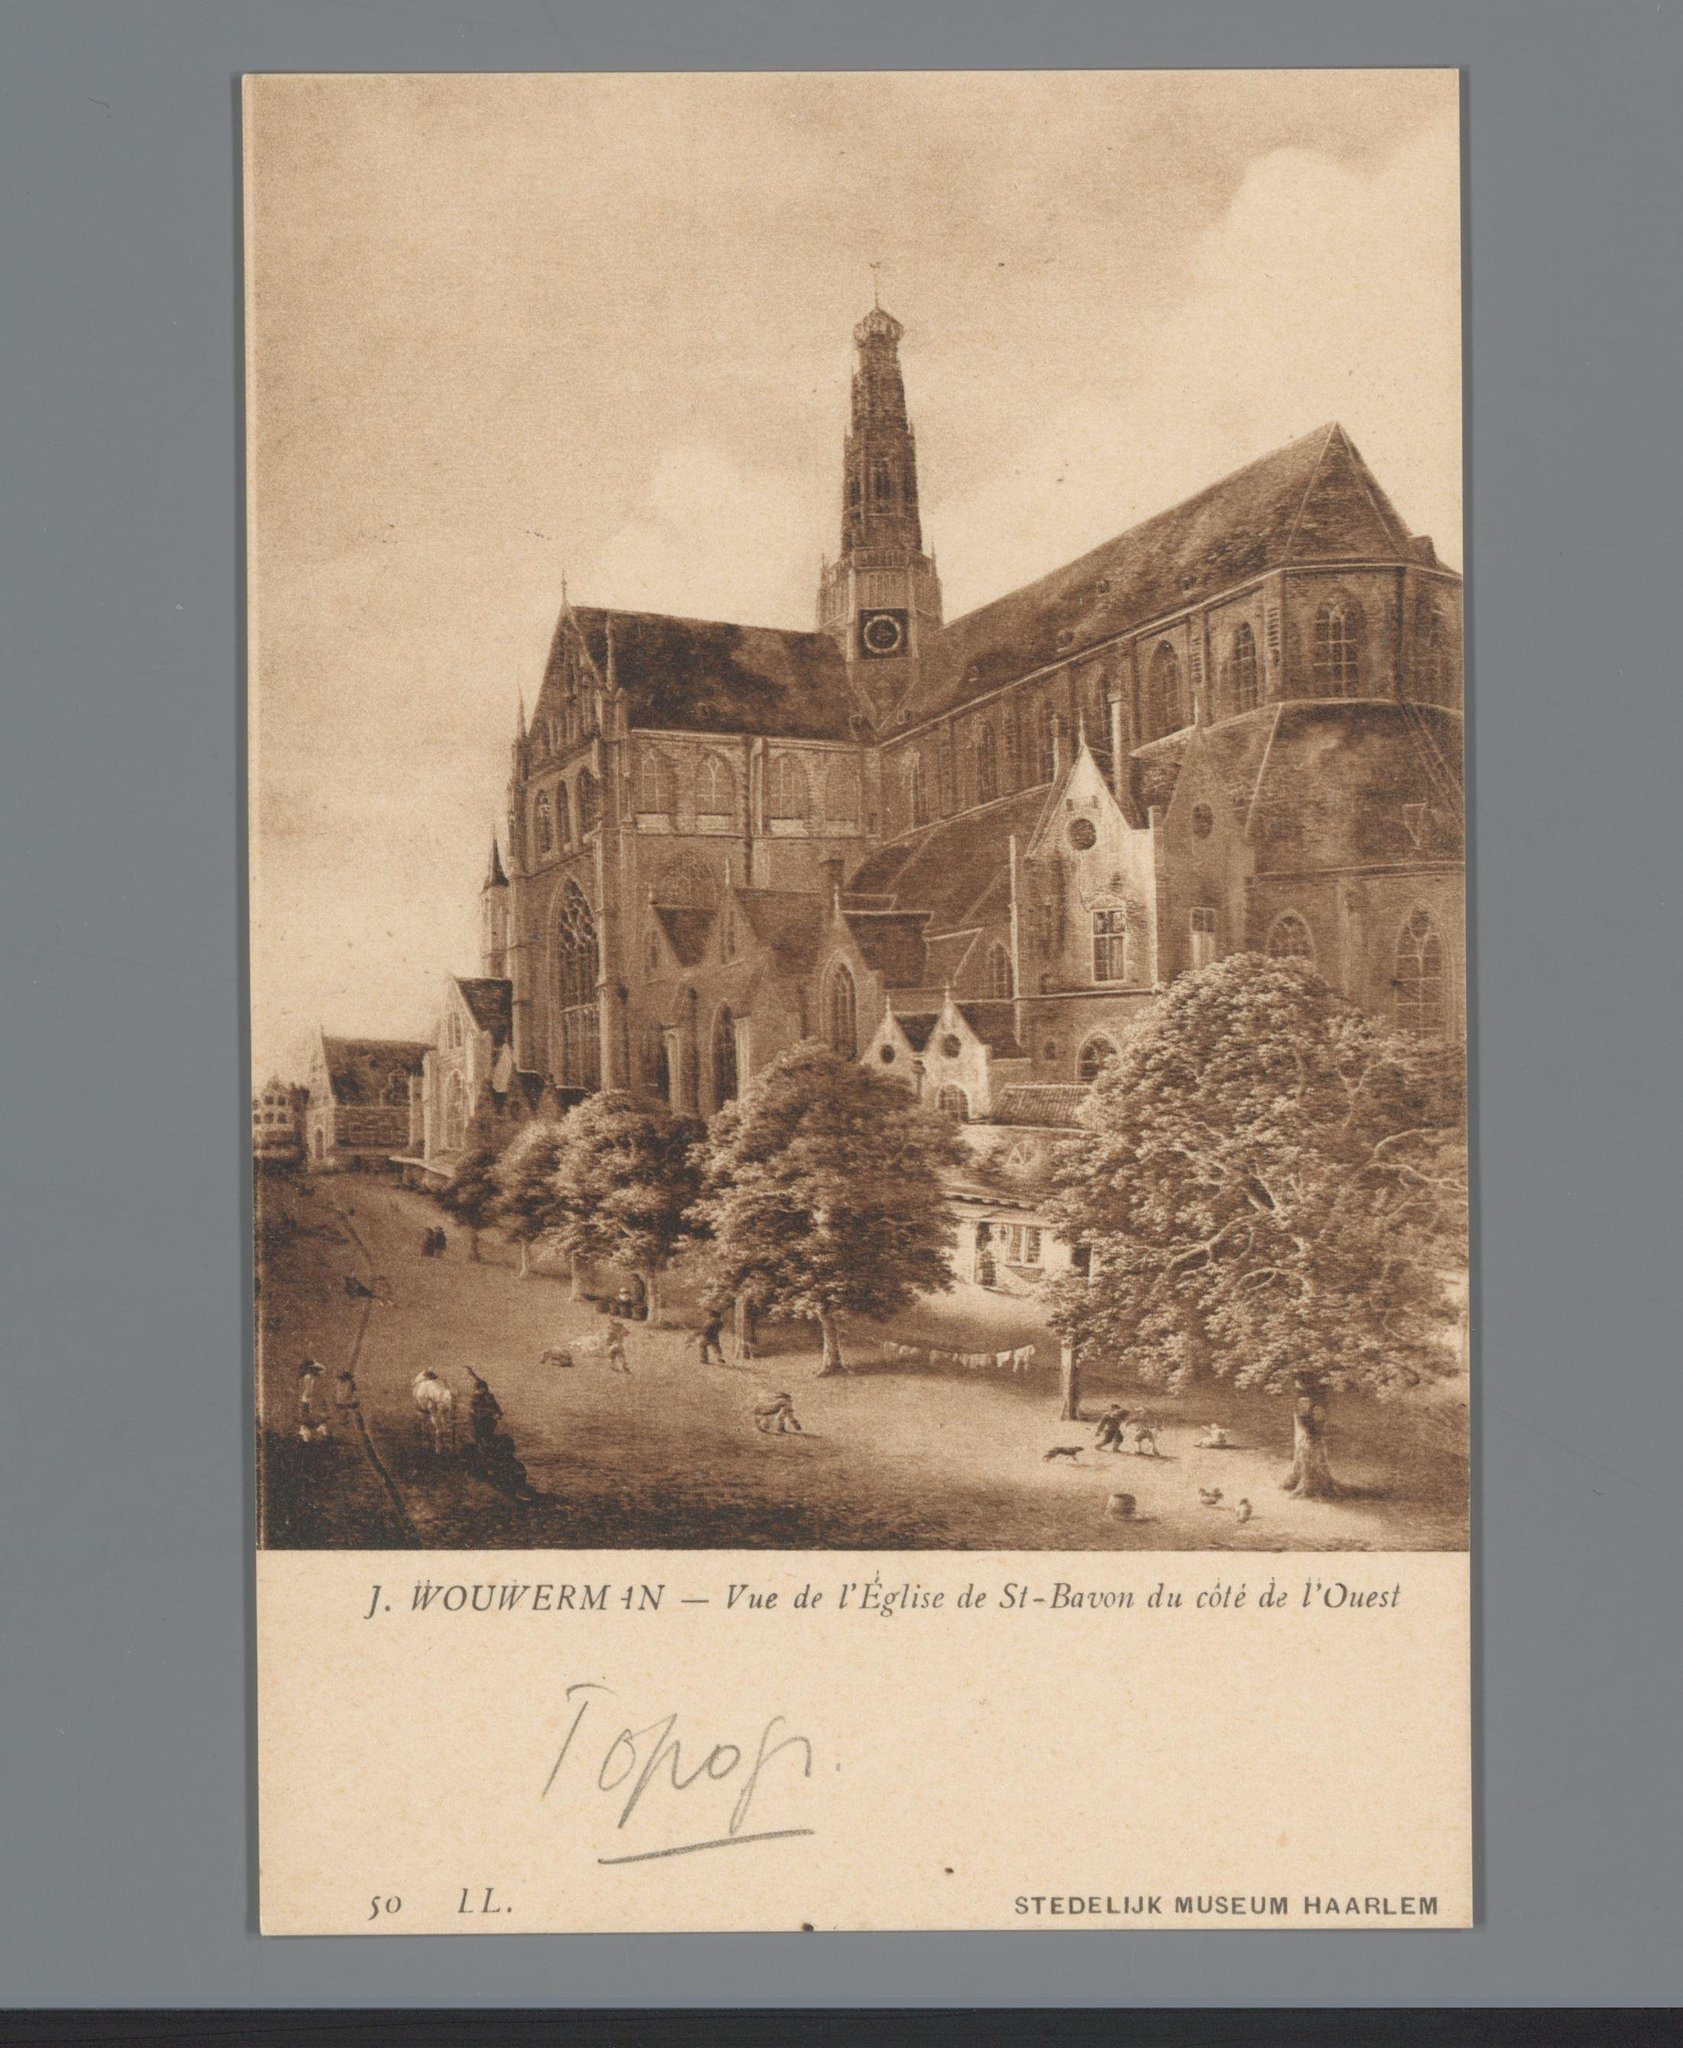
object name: ansichtkaart, prentbriefkaart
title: Reproductie van een schilderij van een gezicht op de Sint-Bavokerk te Haarlem door J. Wouwerman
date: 1900-1920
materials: paper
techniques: photograph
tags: church (exterior)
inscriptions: inscription: ‘J. Wouwerman - Vue de l'Église de St-Bavon du côté de l'Ouest / 50 LL. / Stedelijk Museum Haarlem’, annotation: ‘top/ Haarlem’, annotation: ‘topogr.’